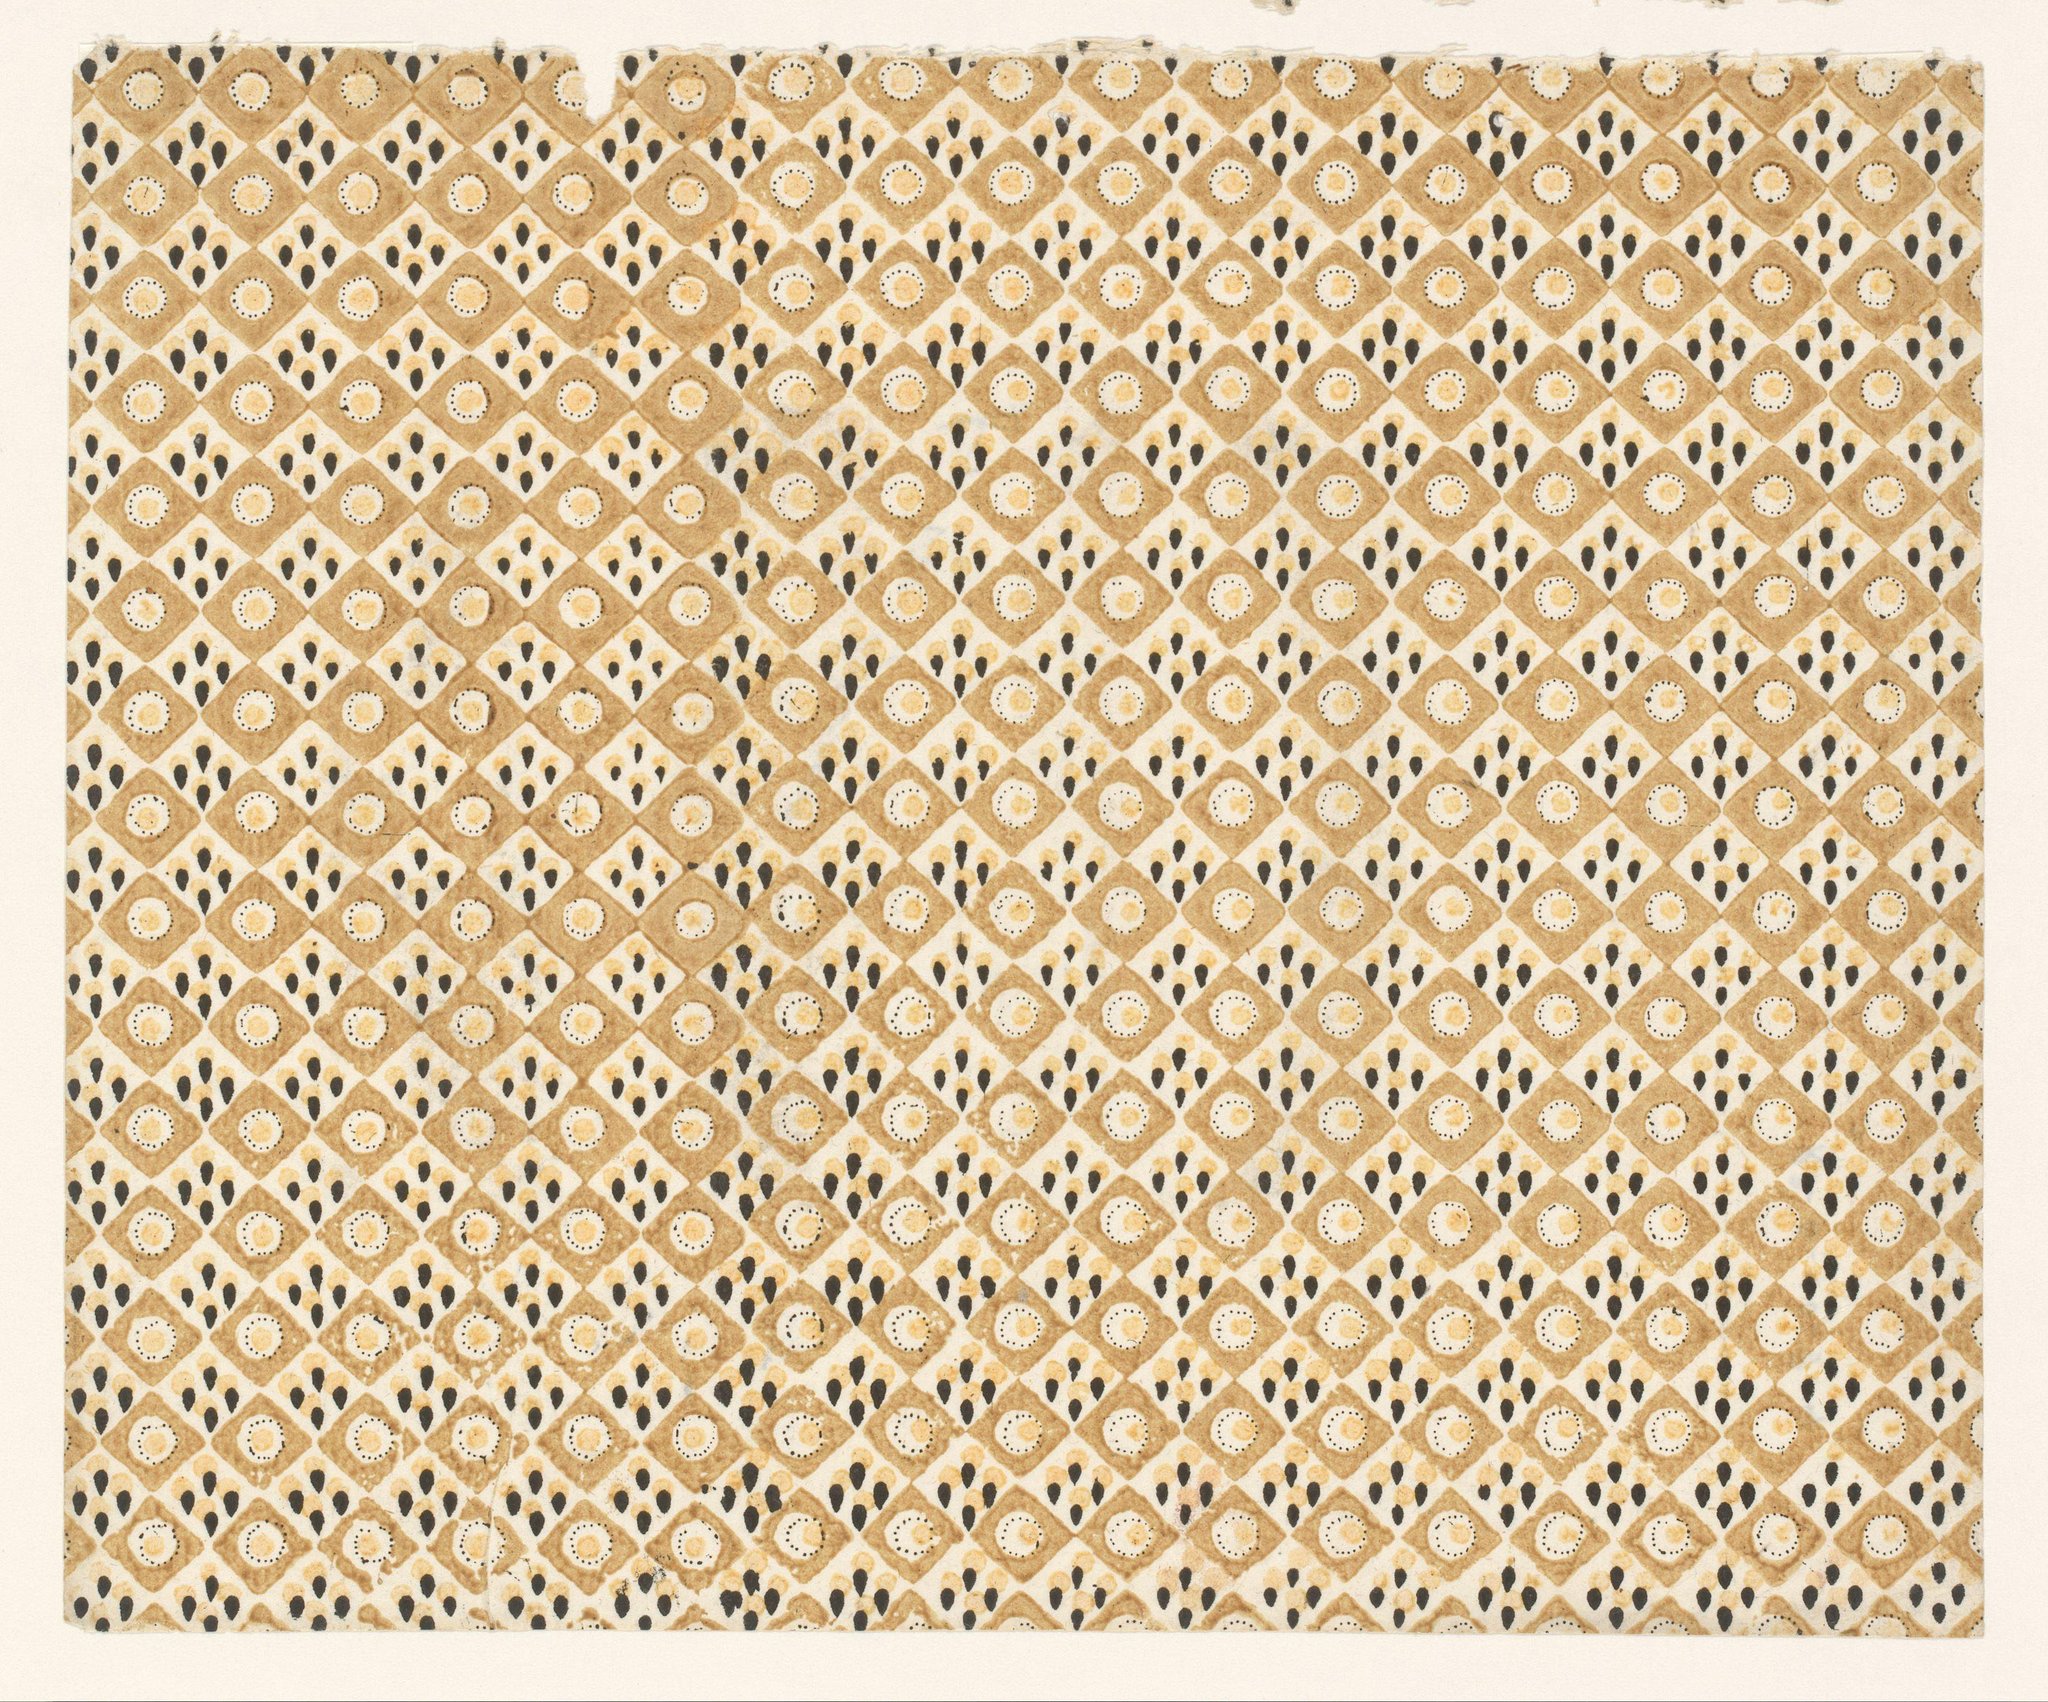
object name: printed paper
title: Blad met ruitpatroon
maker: Anonymous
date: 1750-1950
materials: paper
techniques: printing block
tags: ornament ~ geometric motifs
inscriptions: annotation: ‘Dr. v. Geuns’